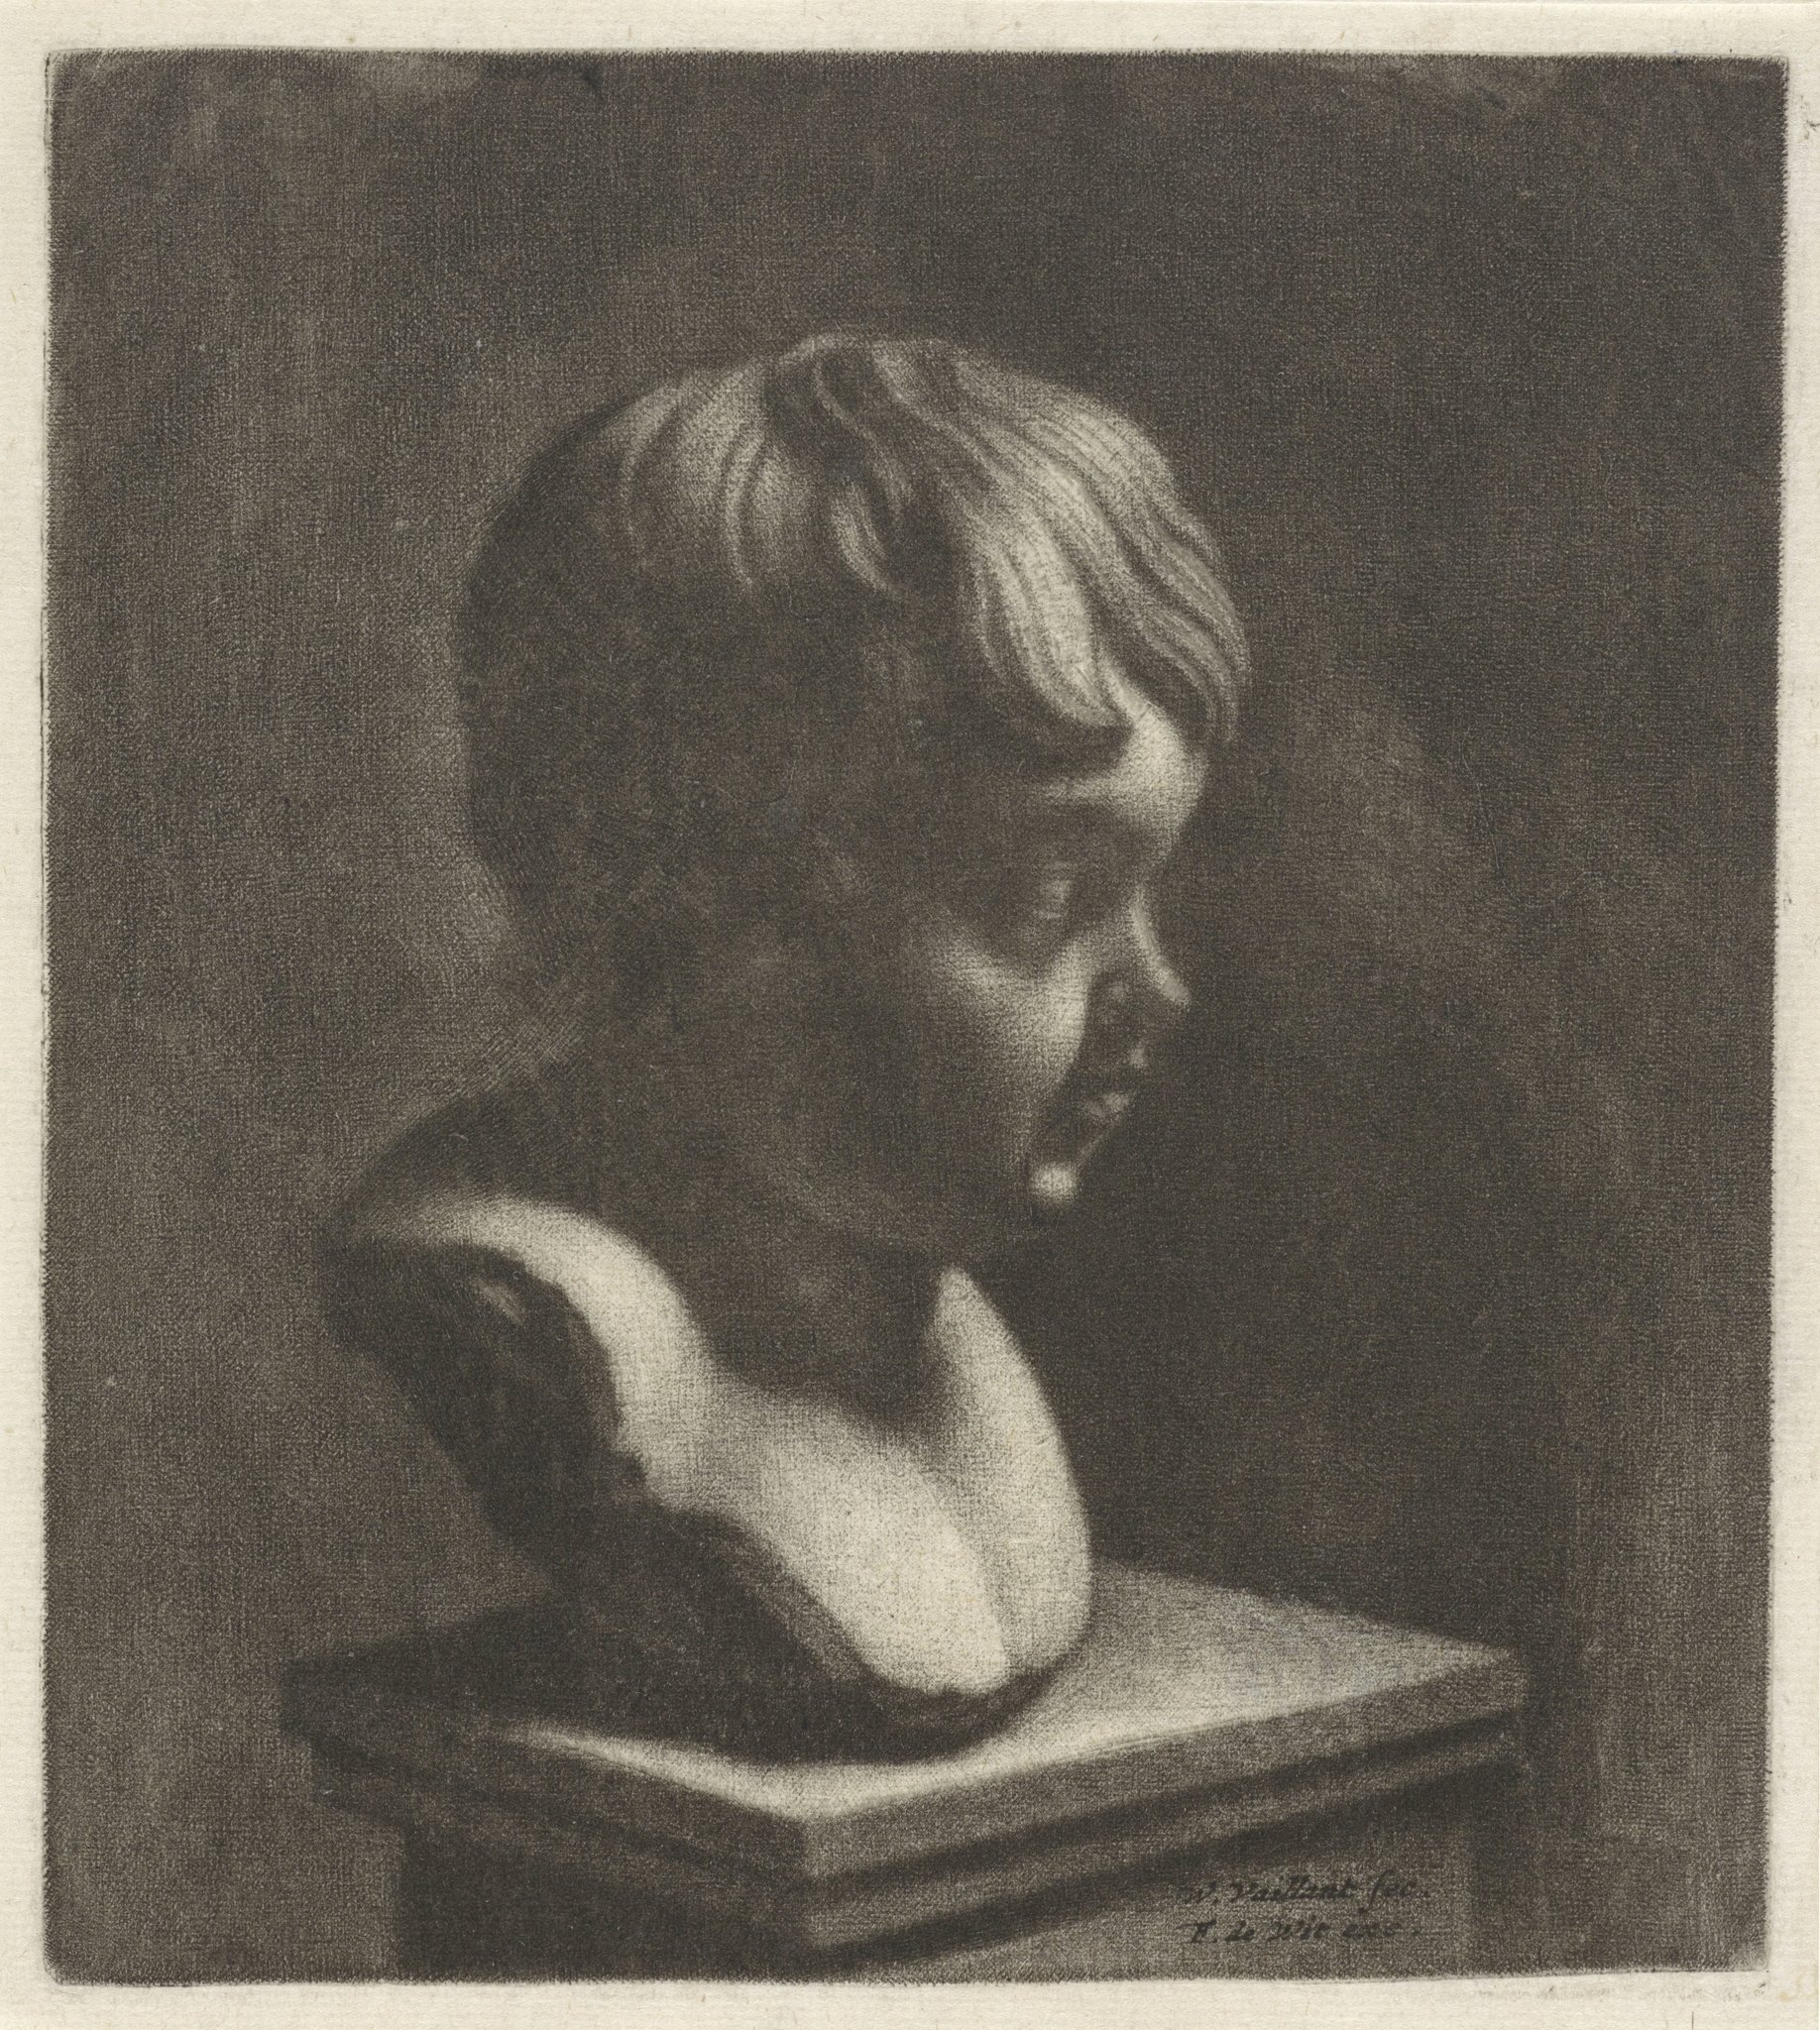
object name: print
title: Borstbeeld van een kind, naar rechts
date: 1658-1706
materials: paper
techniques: mezzotint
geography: amsterdam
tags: child, sculpture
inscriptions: collector's mark: Lugt 2228